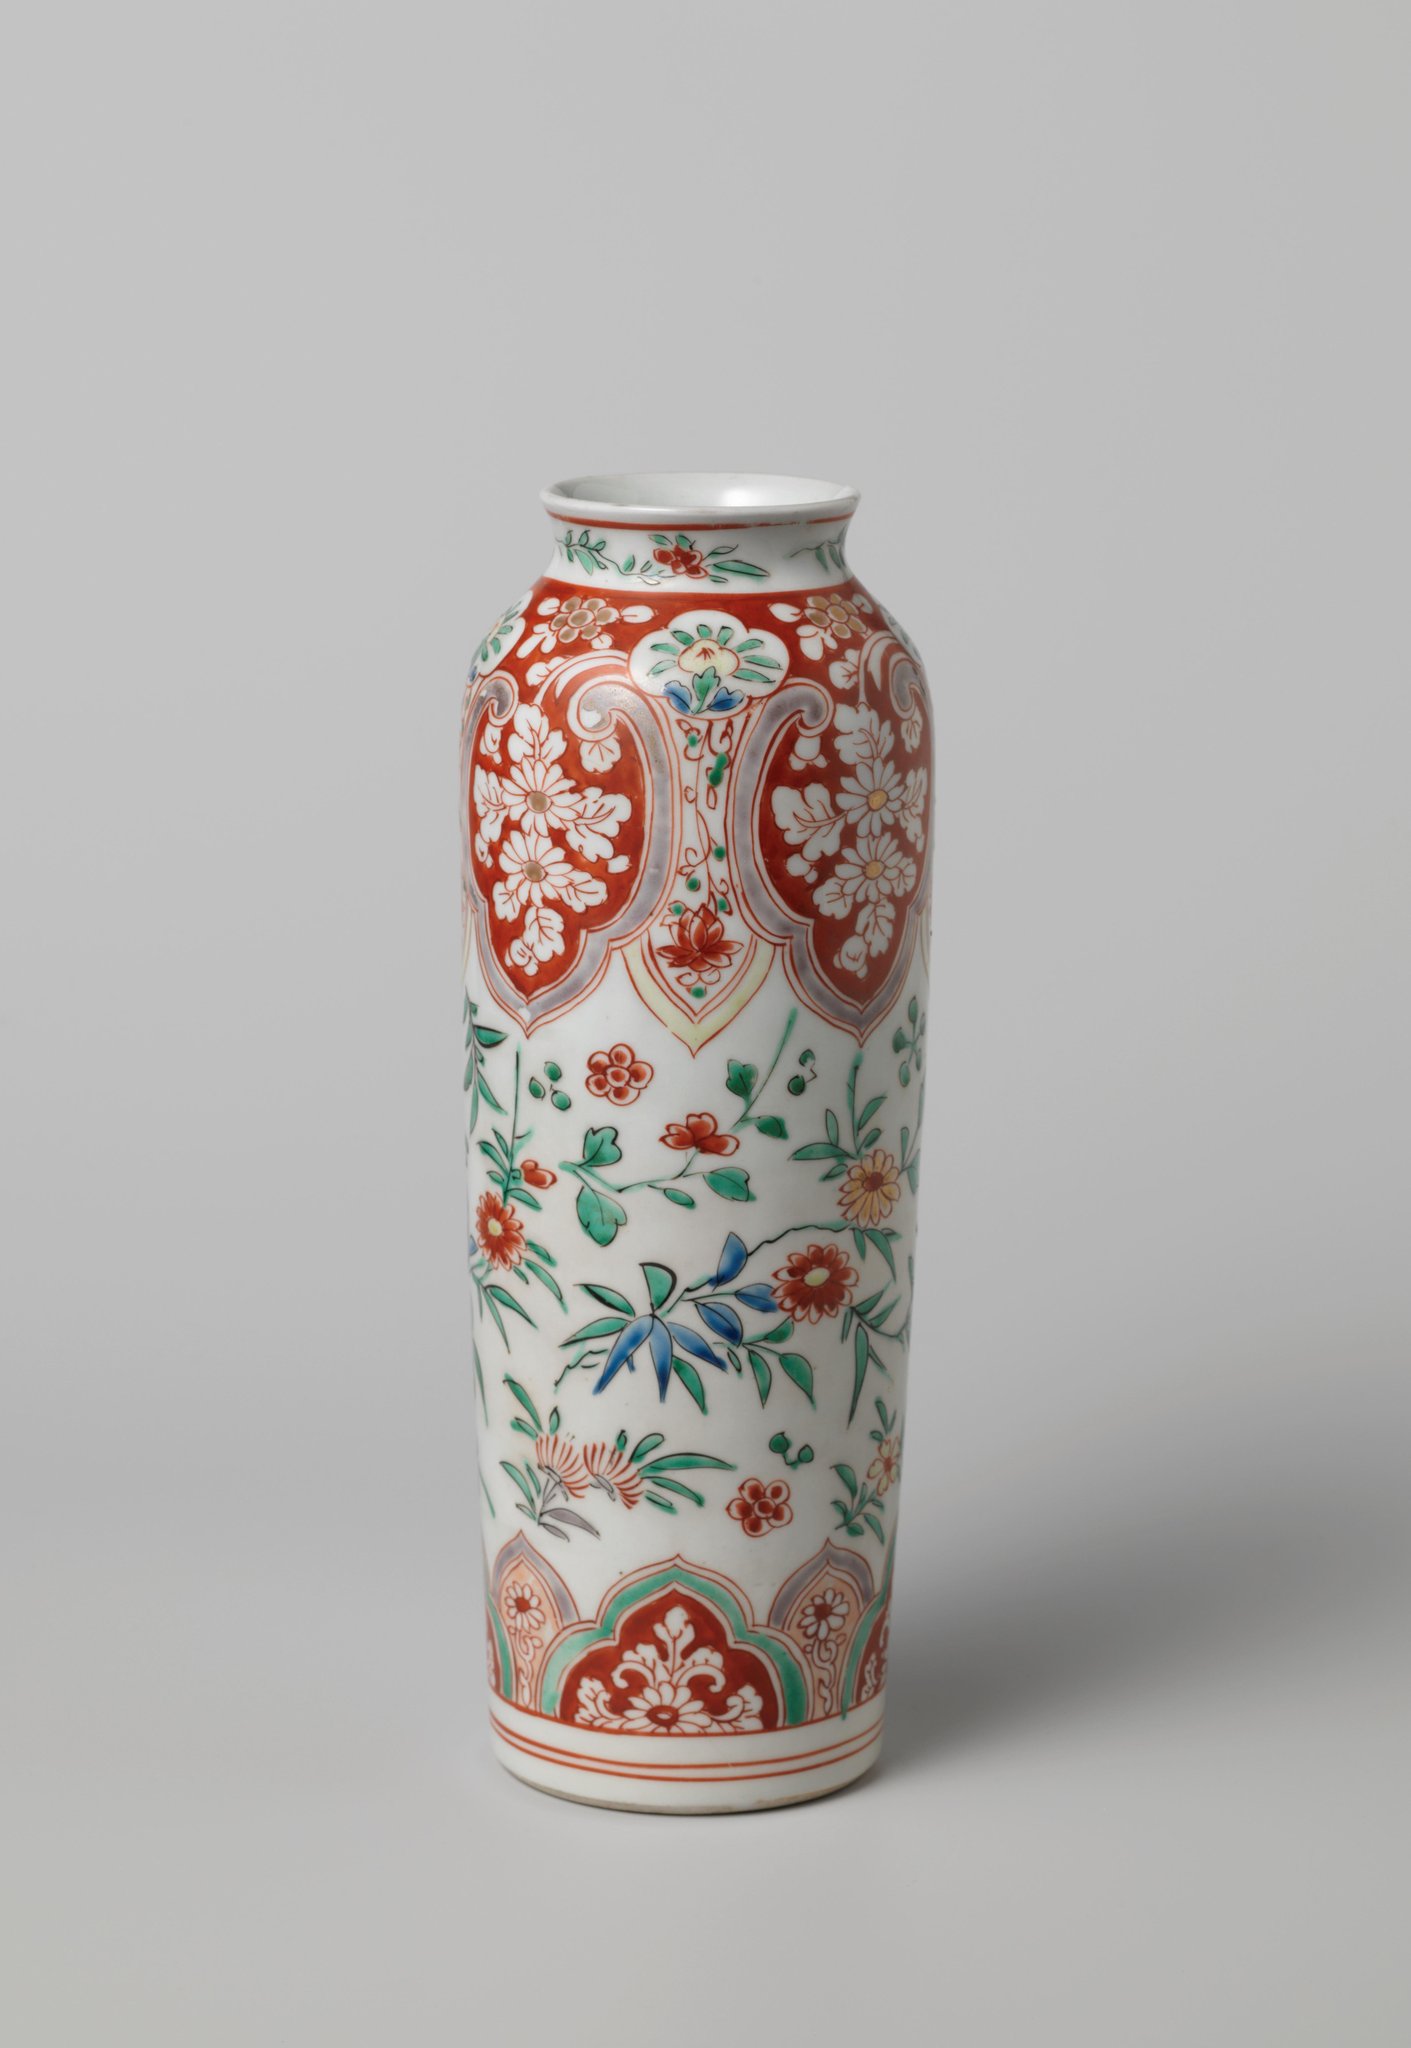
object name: vase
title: Cilindrical vase with flower sprays and scrolls in shaped panels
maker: Anonymous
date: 1700-1725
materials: glaze, gold, paint, porcelain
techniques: firing, gilding, turning, vitrification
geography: japan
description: Box with cover. Japan, Arita. Ca. 1700. Porcelain, decoration in enamels. J.Th. Royer bequest. Two rouleau vases. Japan, Arita. Early 18th centruy. Porcelain, decoration in enamels. J.Th. Royer bequest.